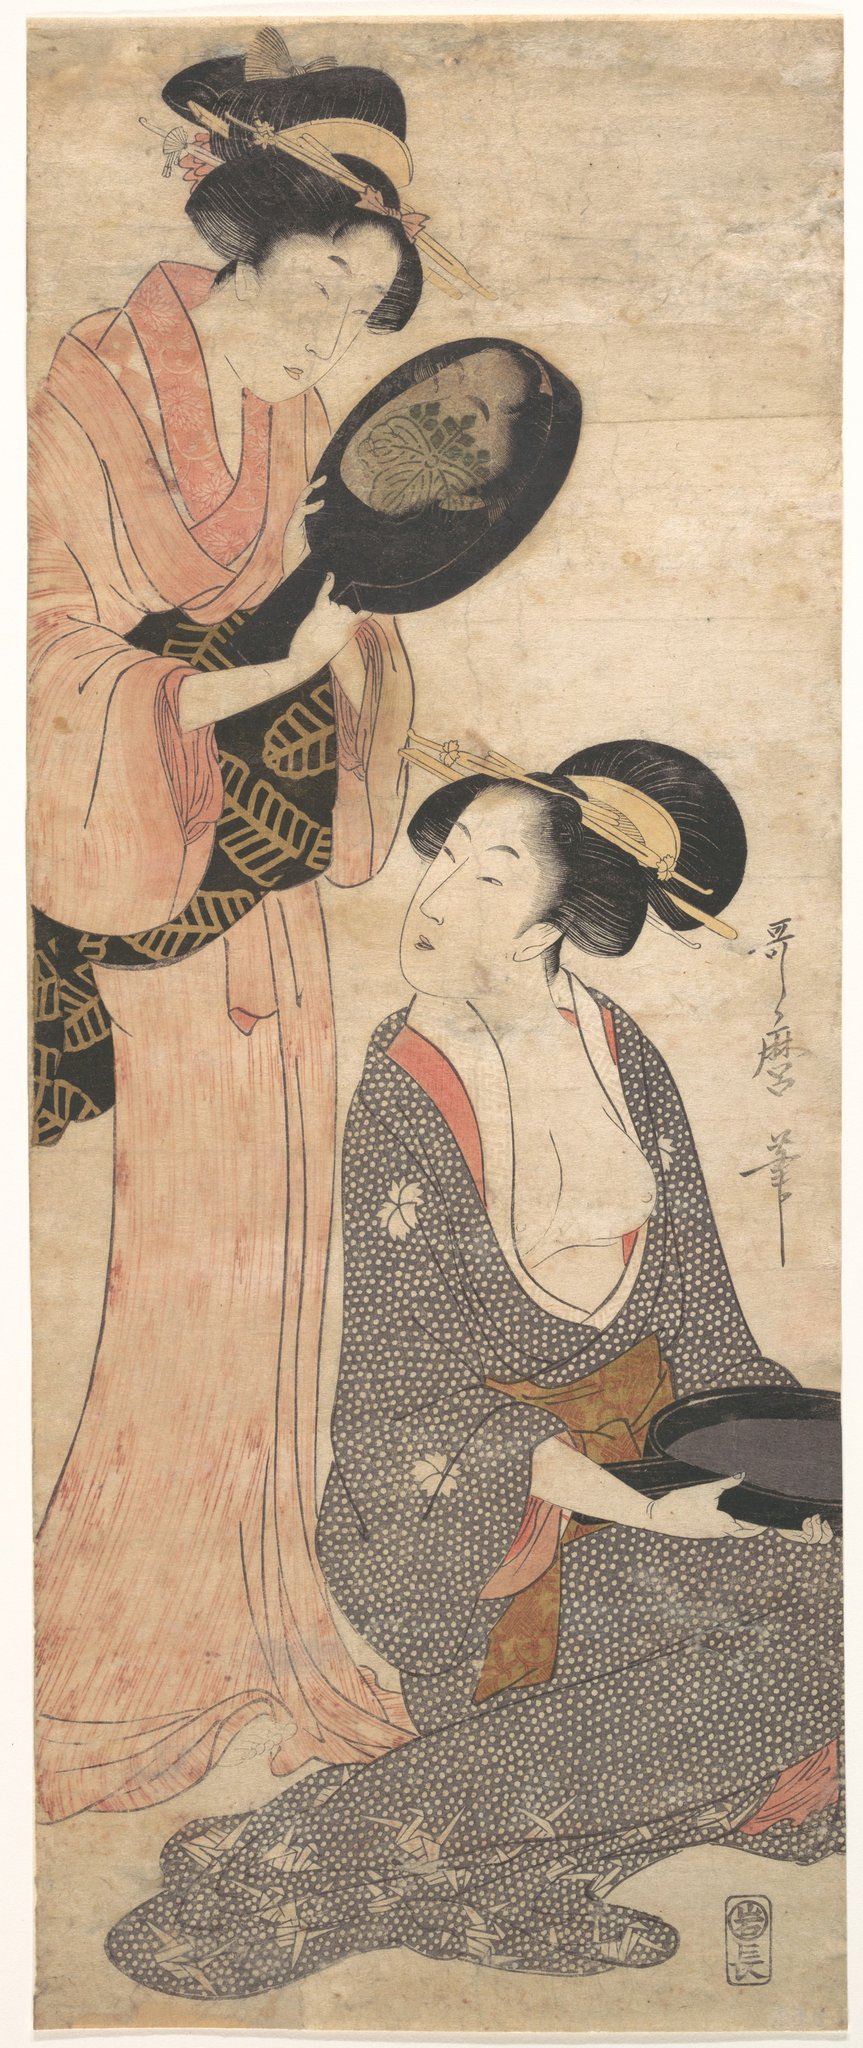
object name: print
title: Two Ladies, Each with a Portion of a Lacquered Mirror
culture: japanese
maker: kitagawa utamaro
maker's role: artist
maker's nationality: japanese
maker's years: 1754-1806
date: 1790-1799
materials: ink, paper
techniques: woodblock print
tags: women,mirrors